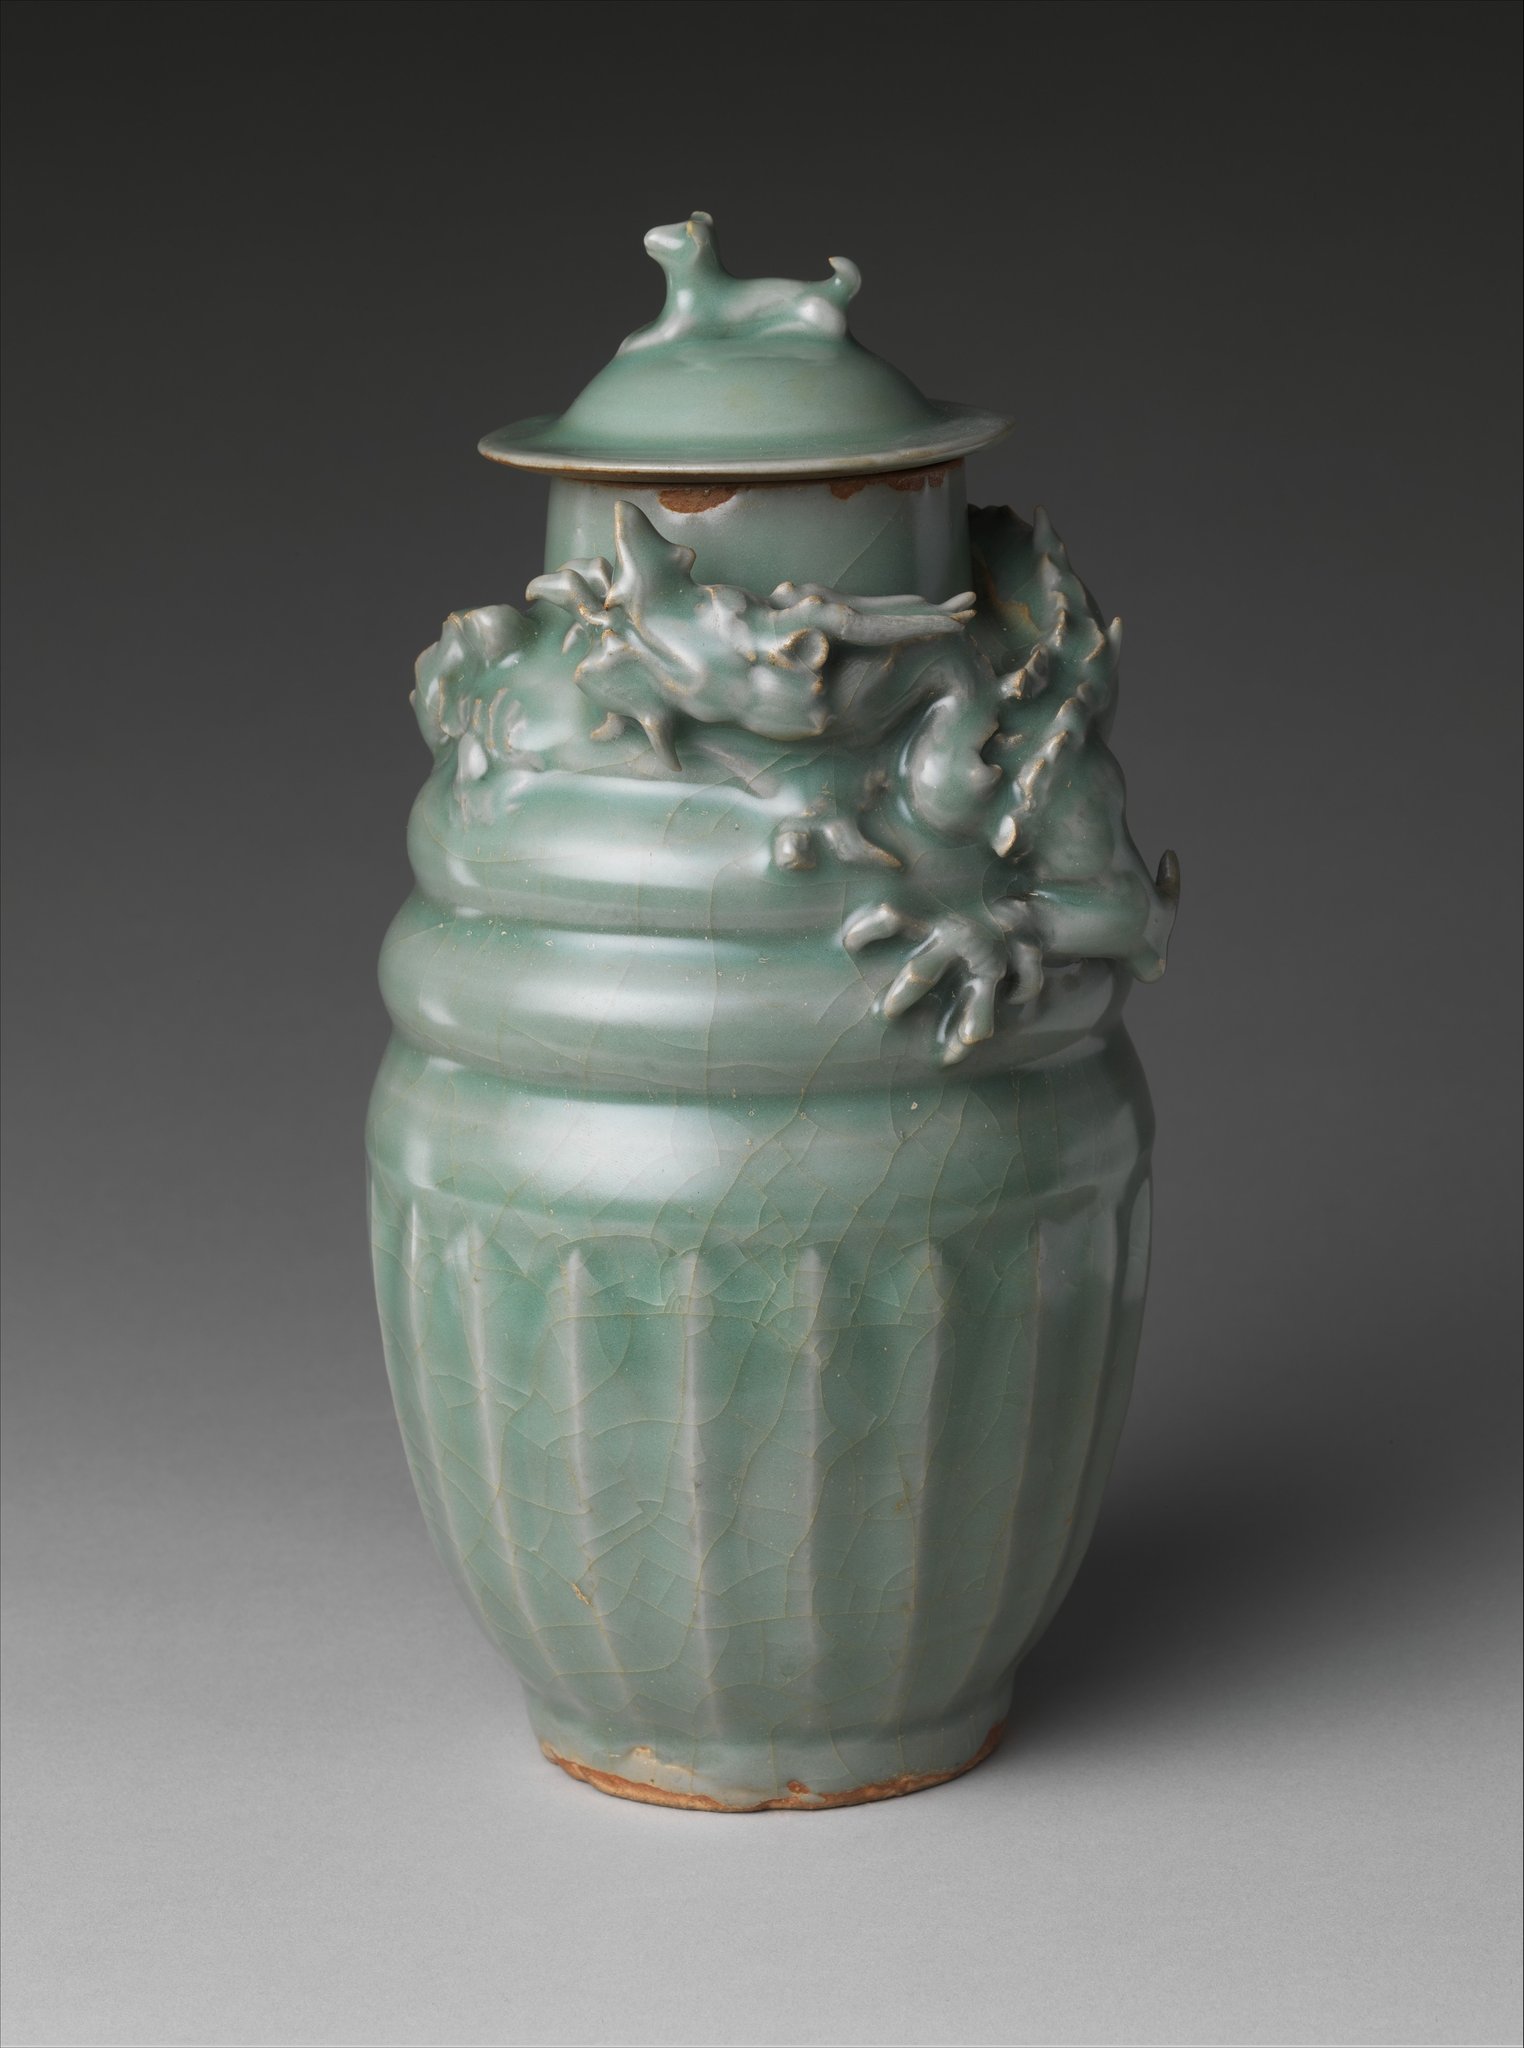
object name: funerary jar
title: Funerary jar with dragon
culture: chinese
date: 1101-1300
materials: ceramic glaze, glaze, porcelain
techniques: carving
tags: dragons